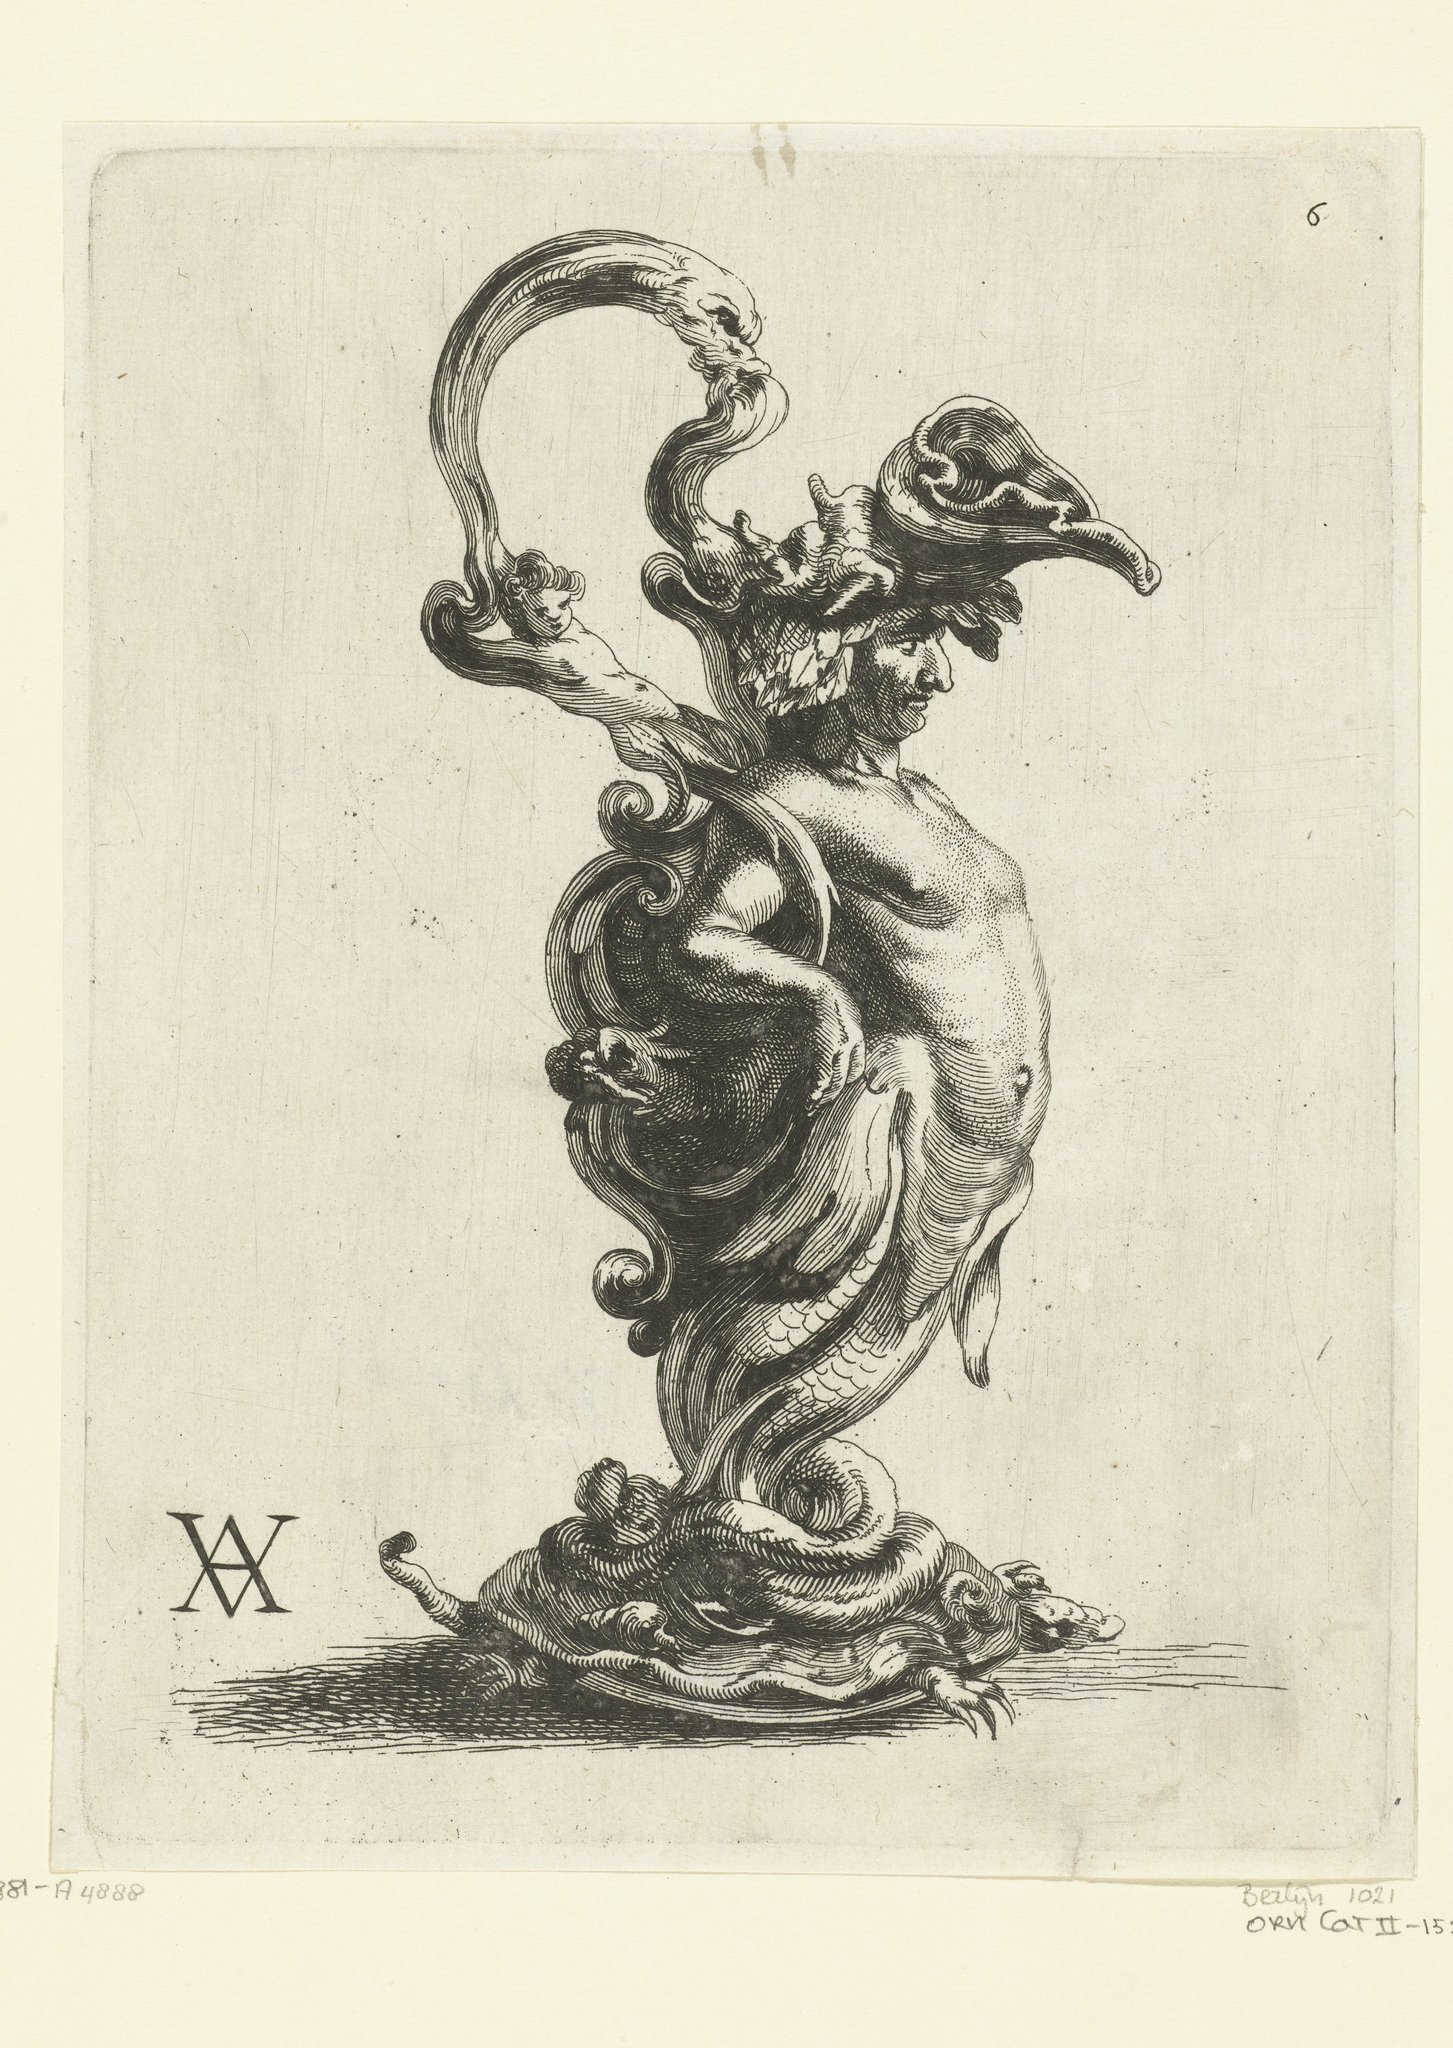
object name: print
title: Modelli artificiosi di vasi diversi d'argento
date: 1646-1652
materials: paper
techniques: etching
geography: utrecht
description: De kan heeft een voet in de vorm van een schildpad.